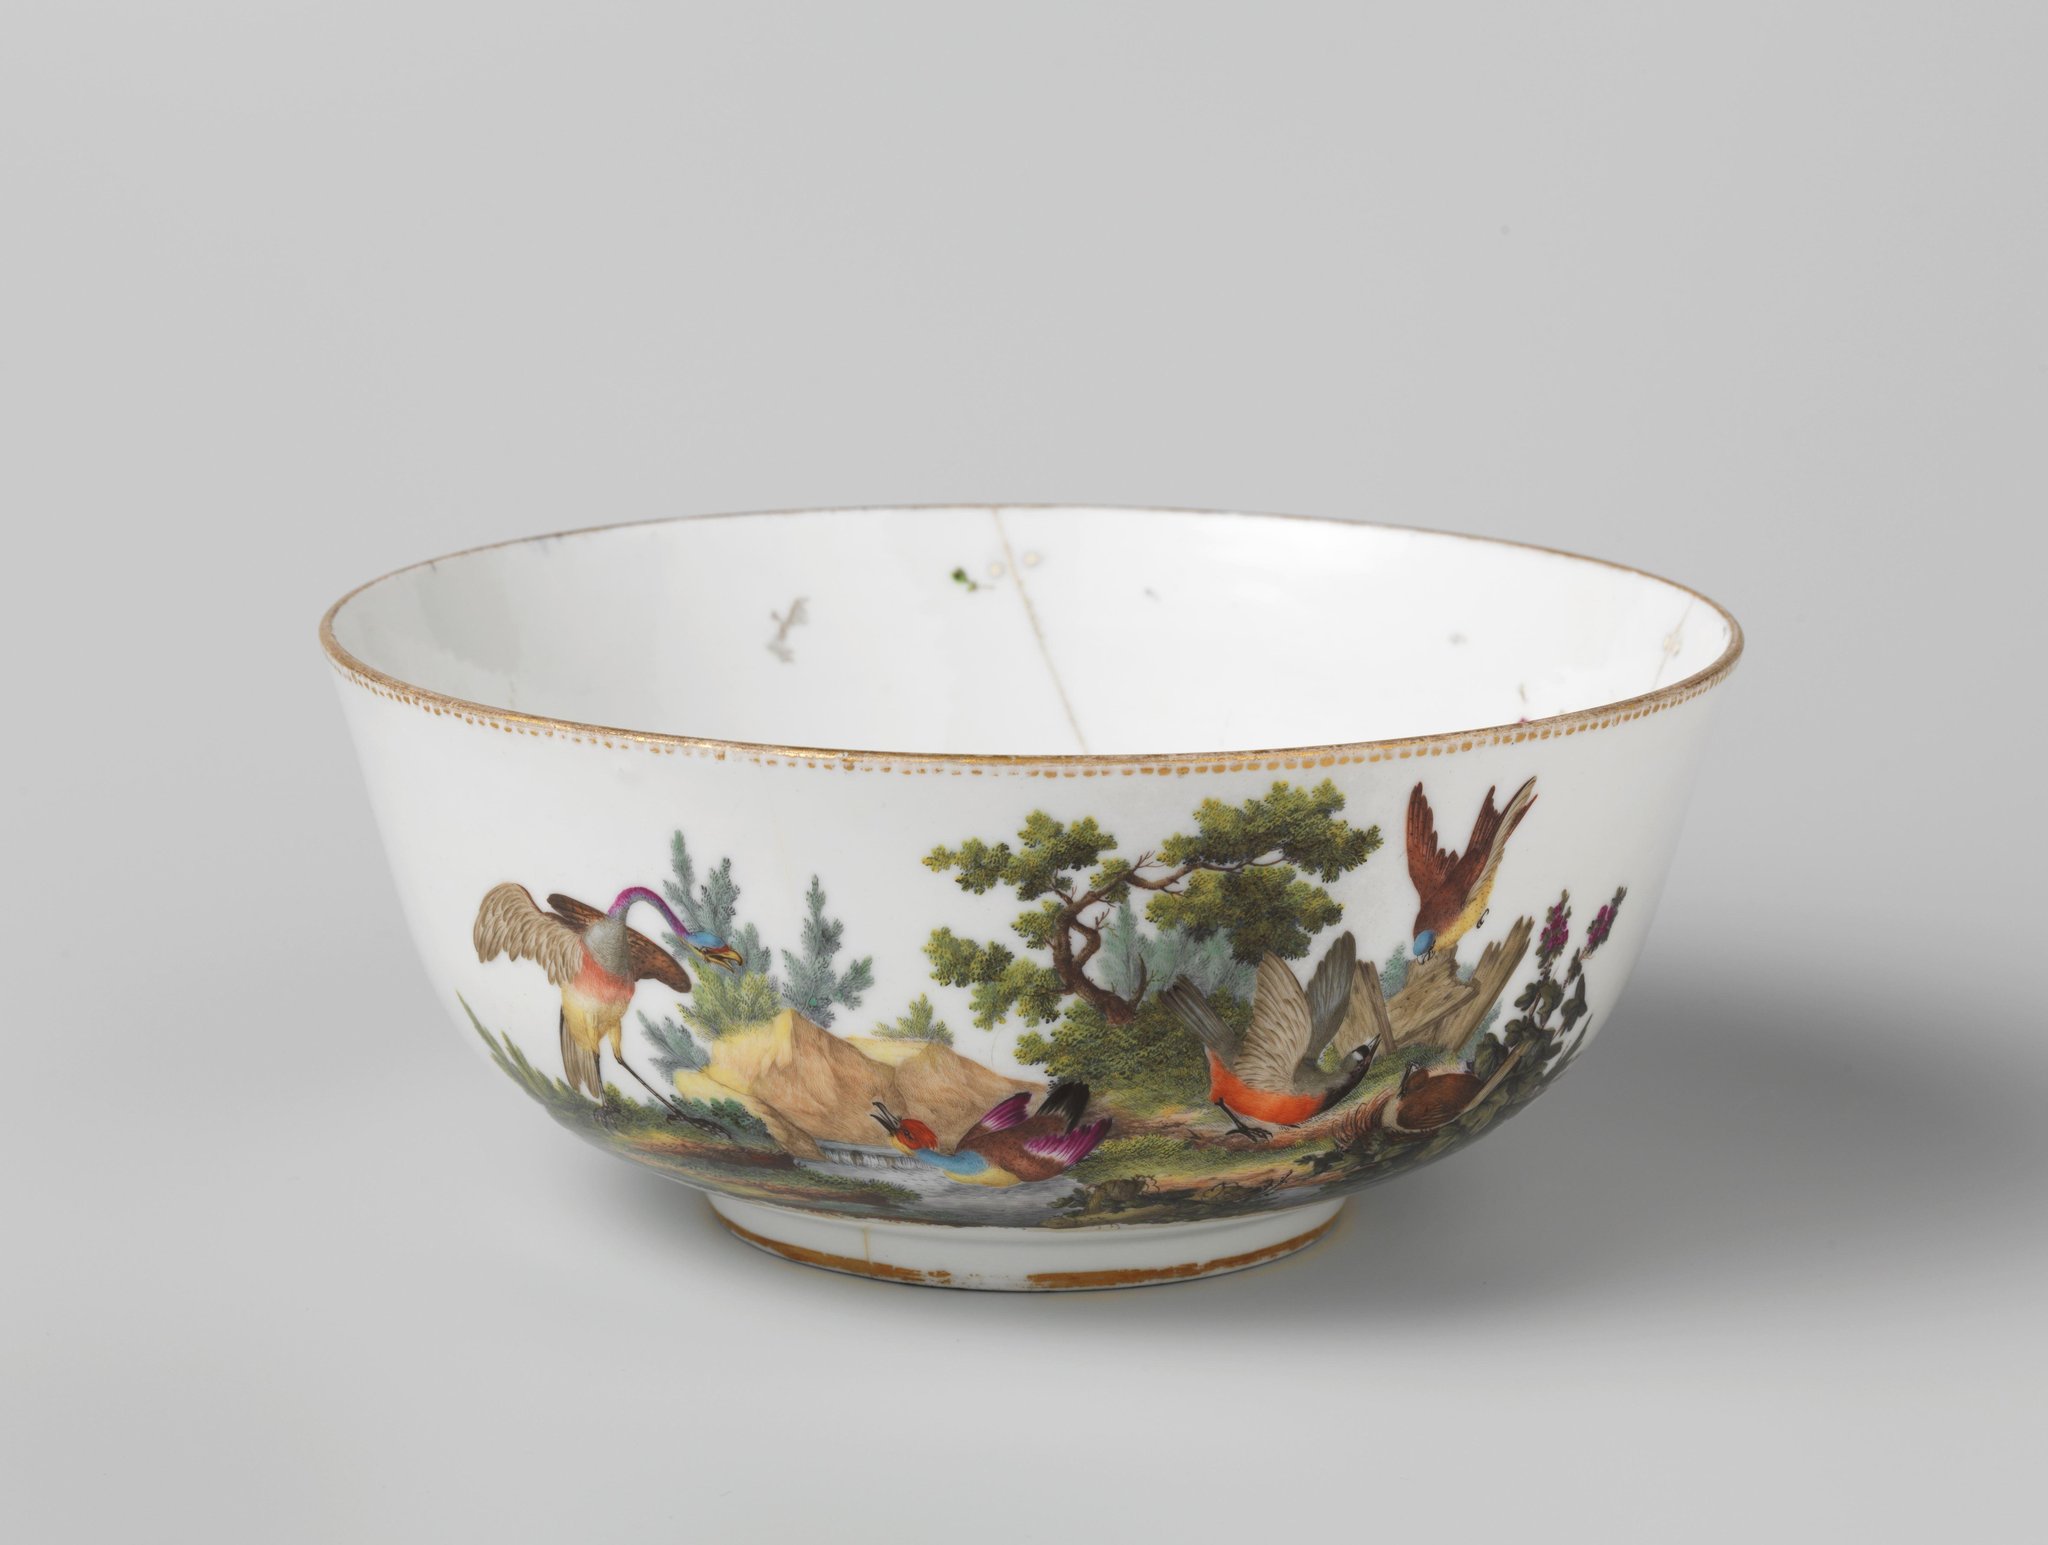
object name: slop bowl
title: Spoelkom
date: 1784-1809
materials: porcelain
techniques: painted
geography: amstel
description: Spoelkom veelkleurig beschilderd met vogels in een landschap. Langs de rand een bies in goud. Gemerkt: Amstel in blauw onder het glazuur.